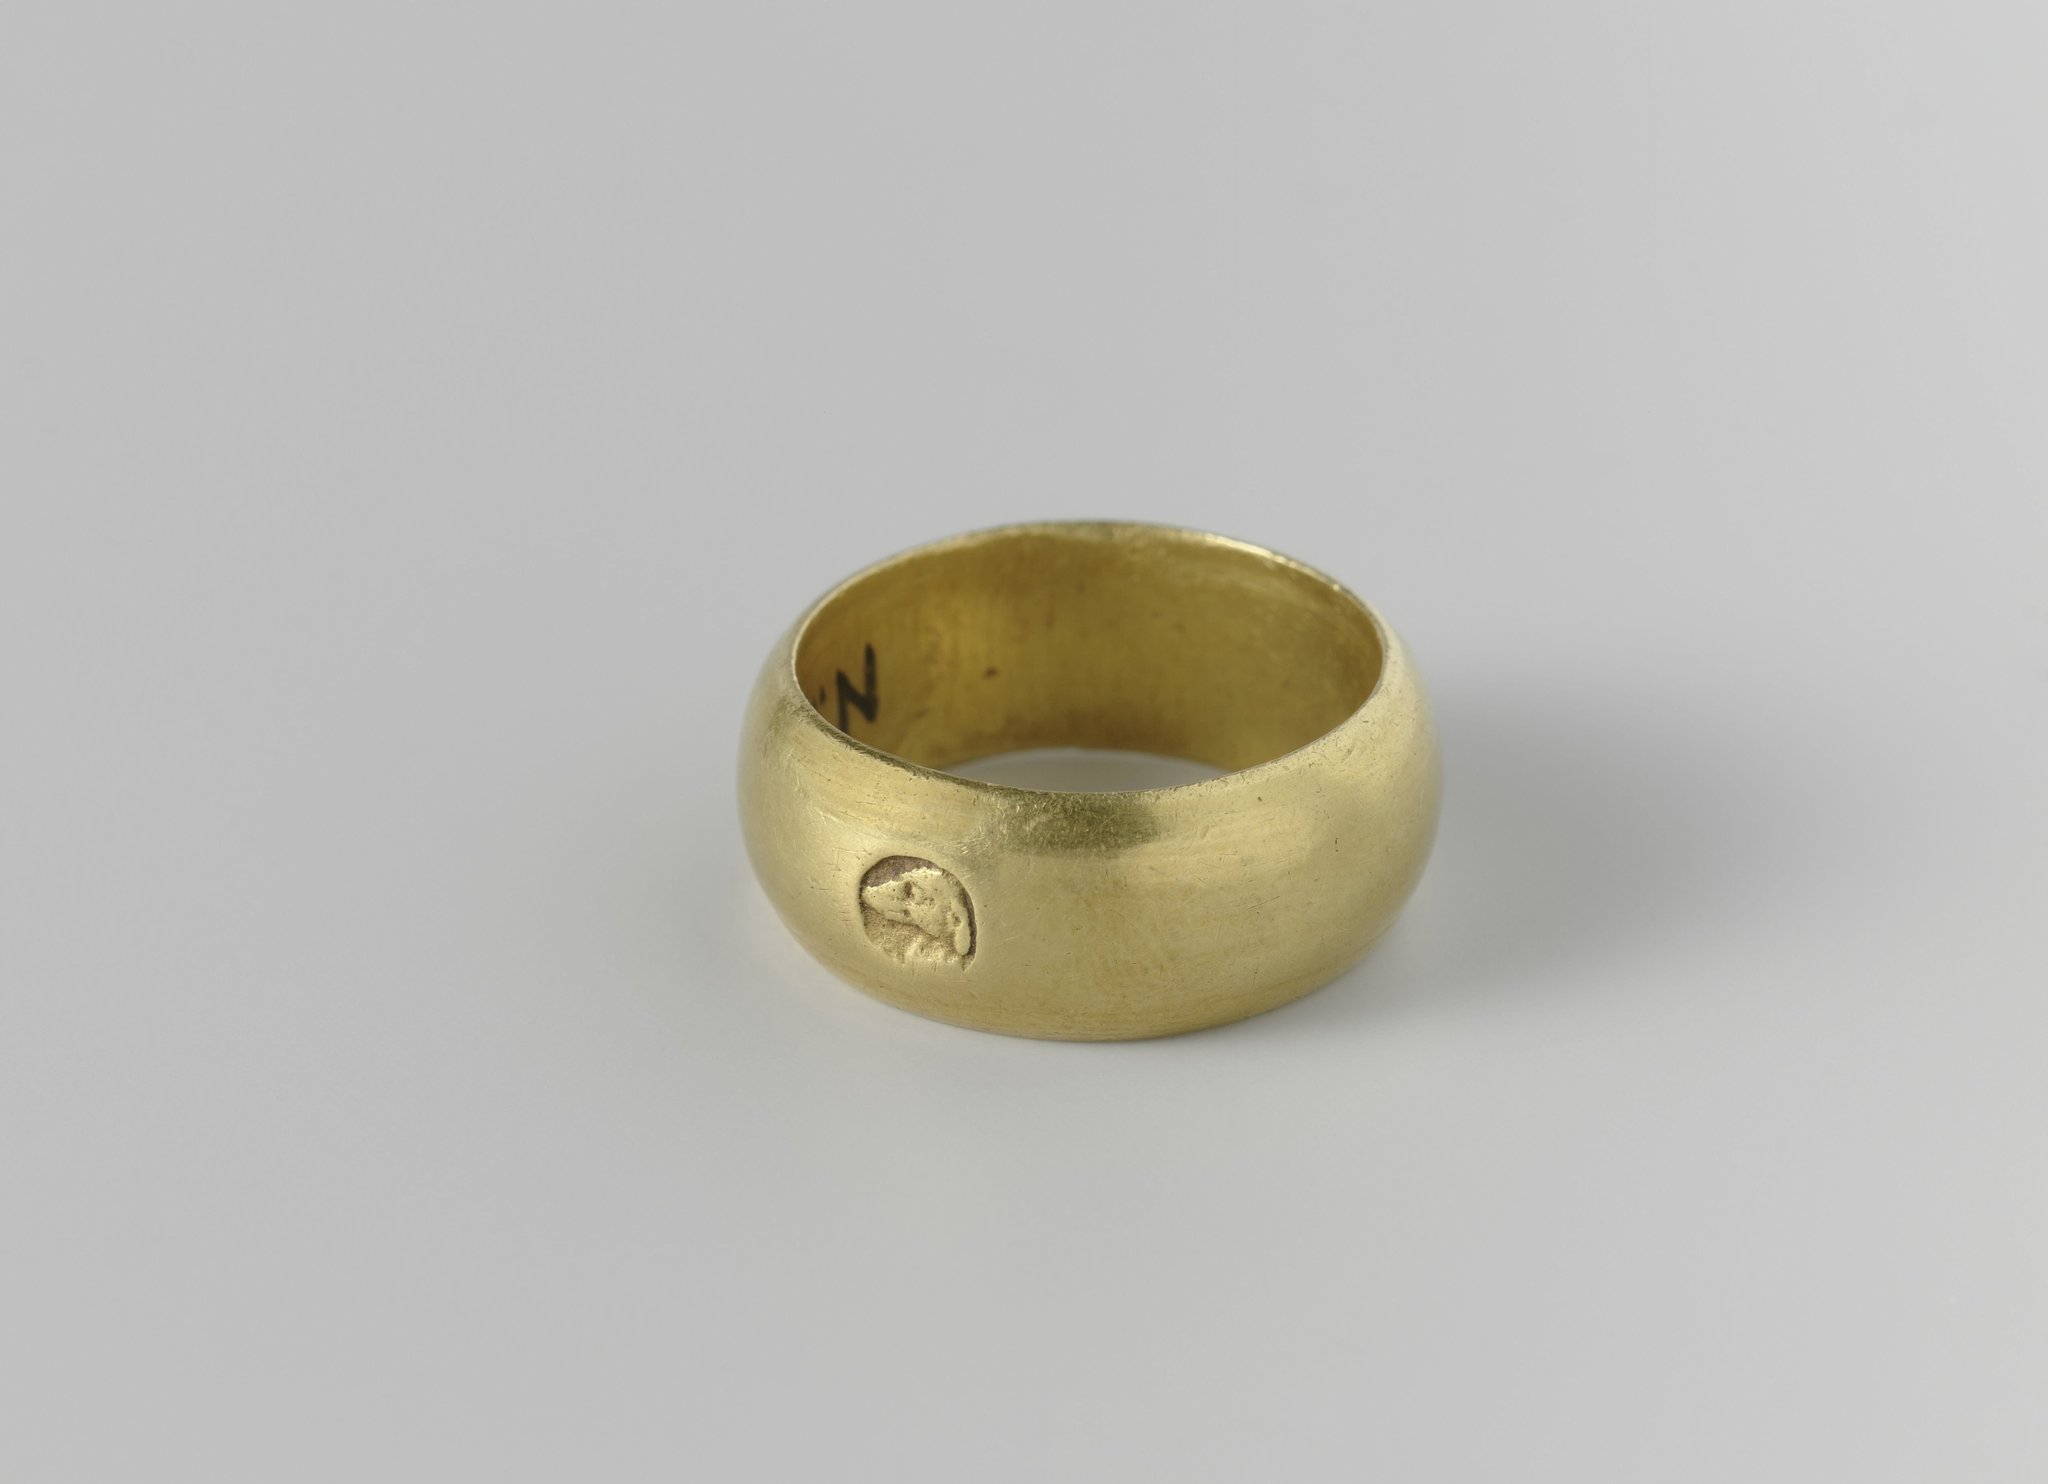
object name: ring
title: Ring met jachthond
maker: Anonymous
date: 1770-1775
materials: gold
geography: netherlands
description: Gladde ring van goud. Aan de buitenzijde gemerkt met een hondekop.